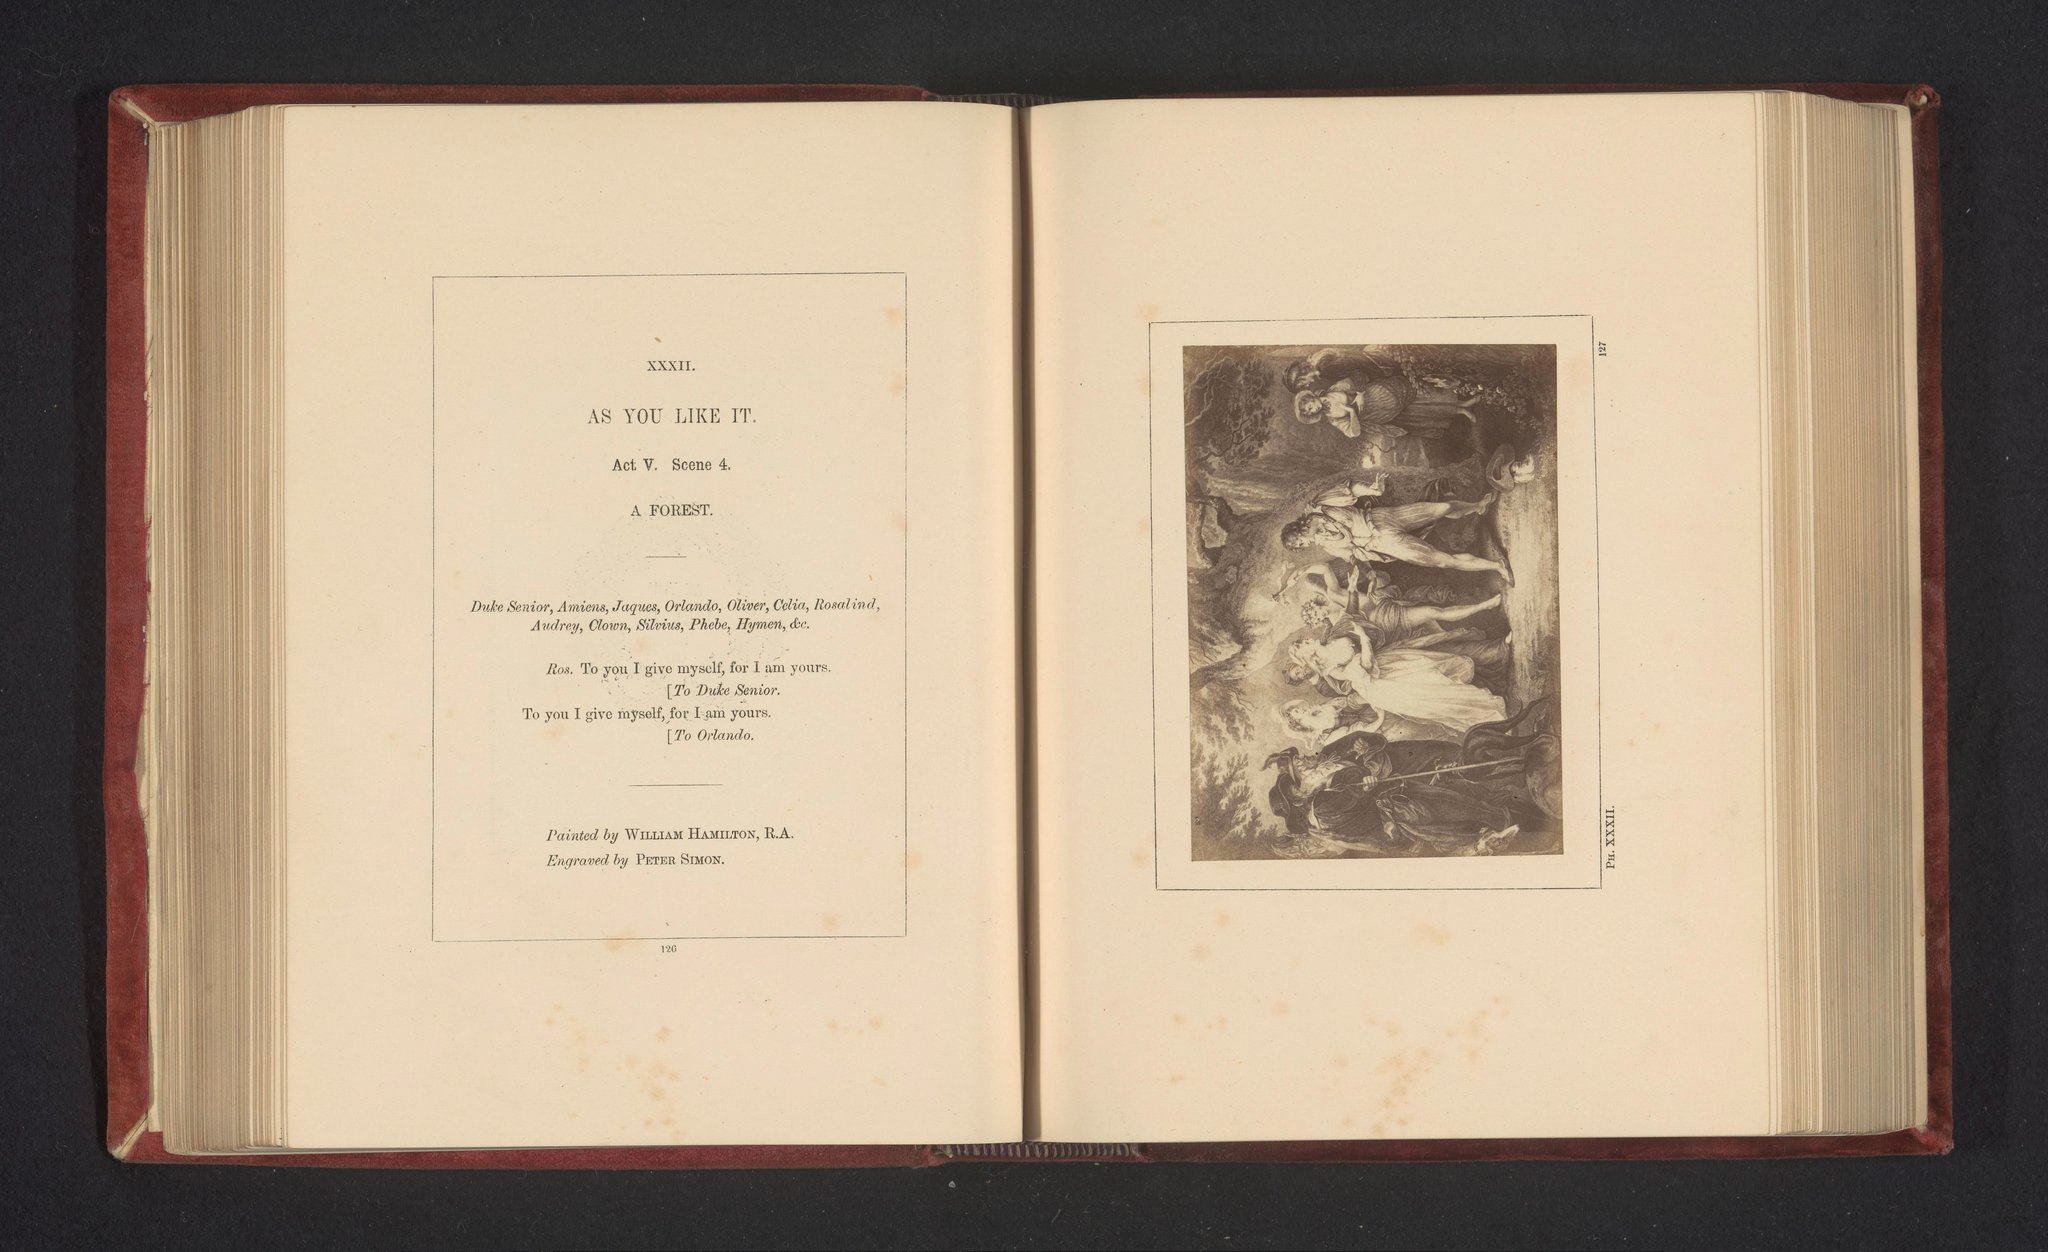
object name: page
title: Fotoreproductie van een prent naar een schilderij door William Hamilton, voorstellend een scene uit Naar het u bevalt door William Shakespeare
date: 1854-1864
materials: photographic support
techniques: albumen print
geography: london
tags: specific works of literature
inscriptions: number: ‘Ph. XXXII. 127’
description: Te zien is akte V, scene 4 met een gezelschap in het bos.